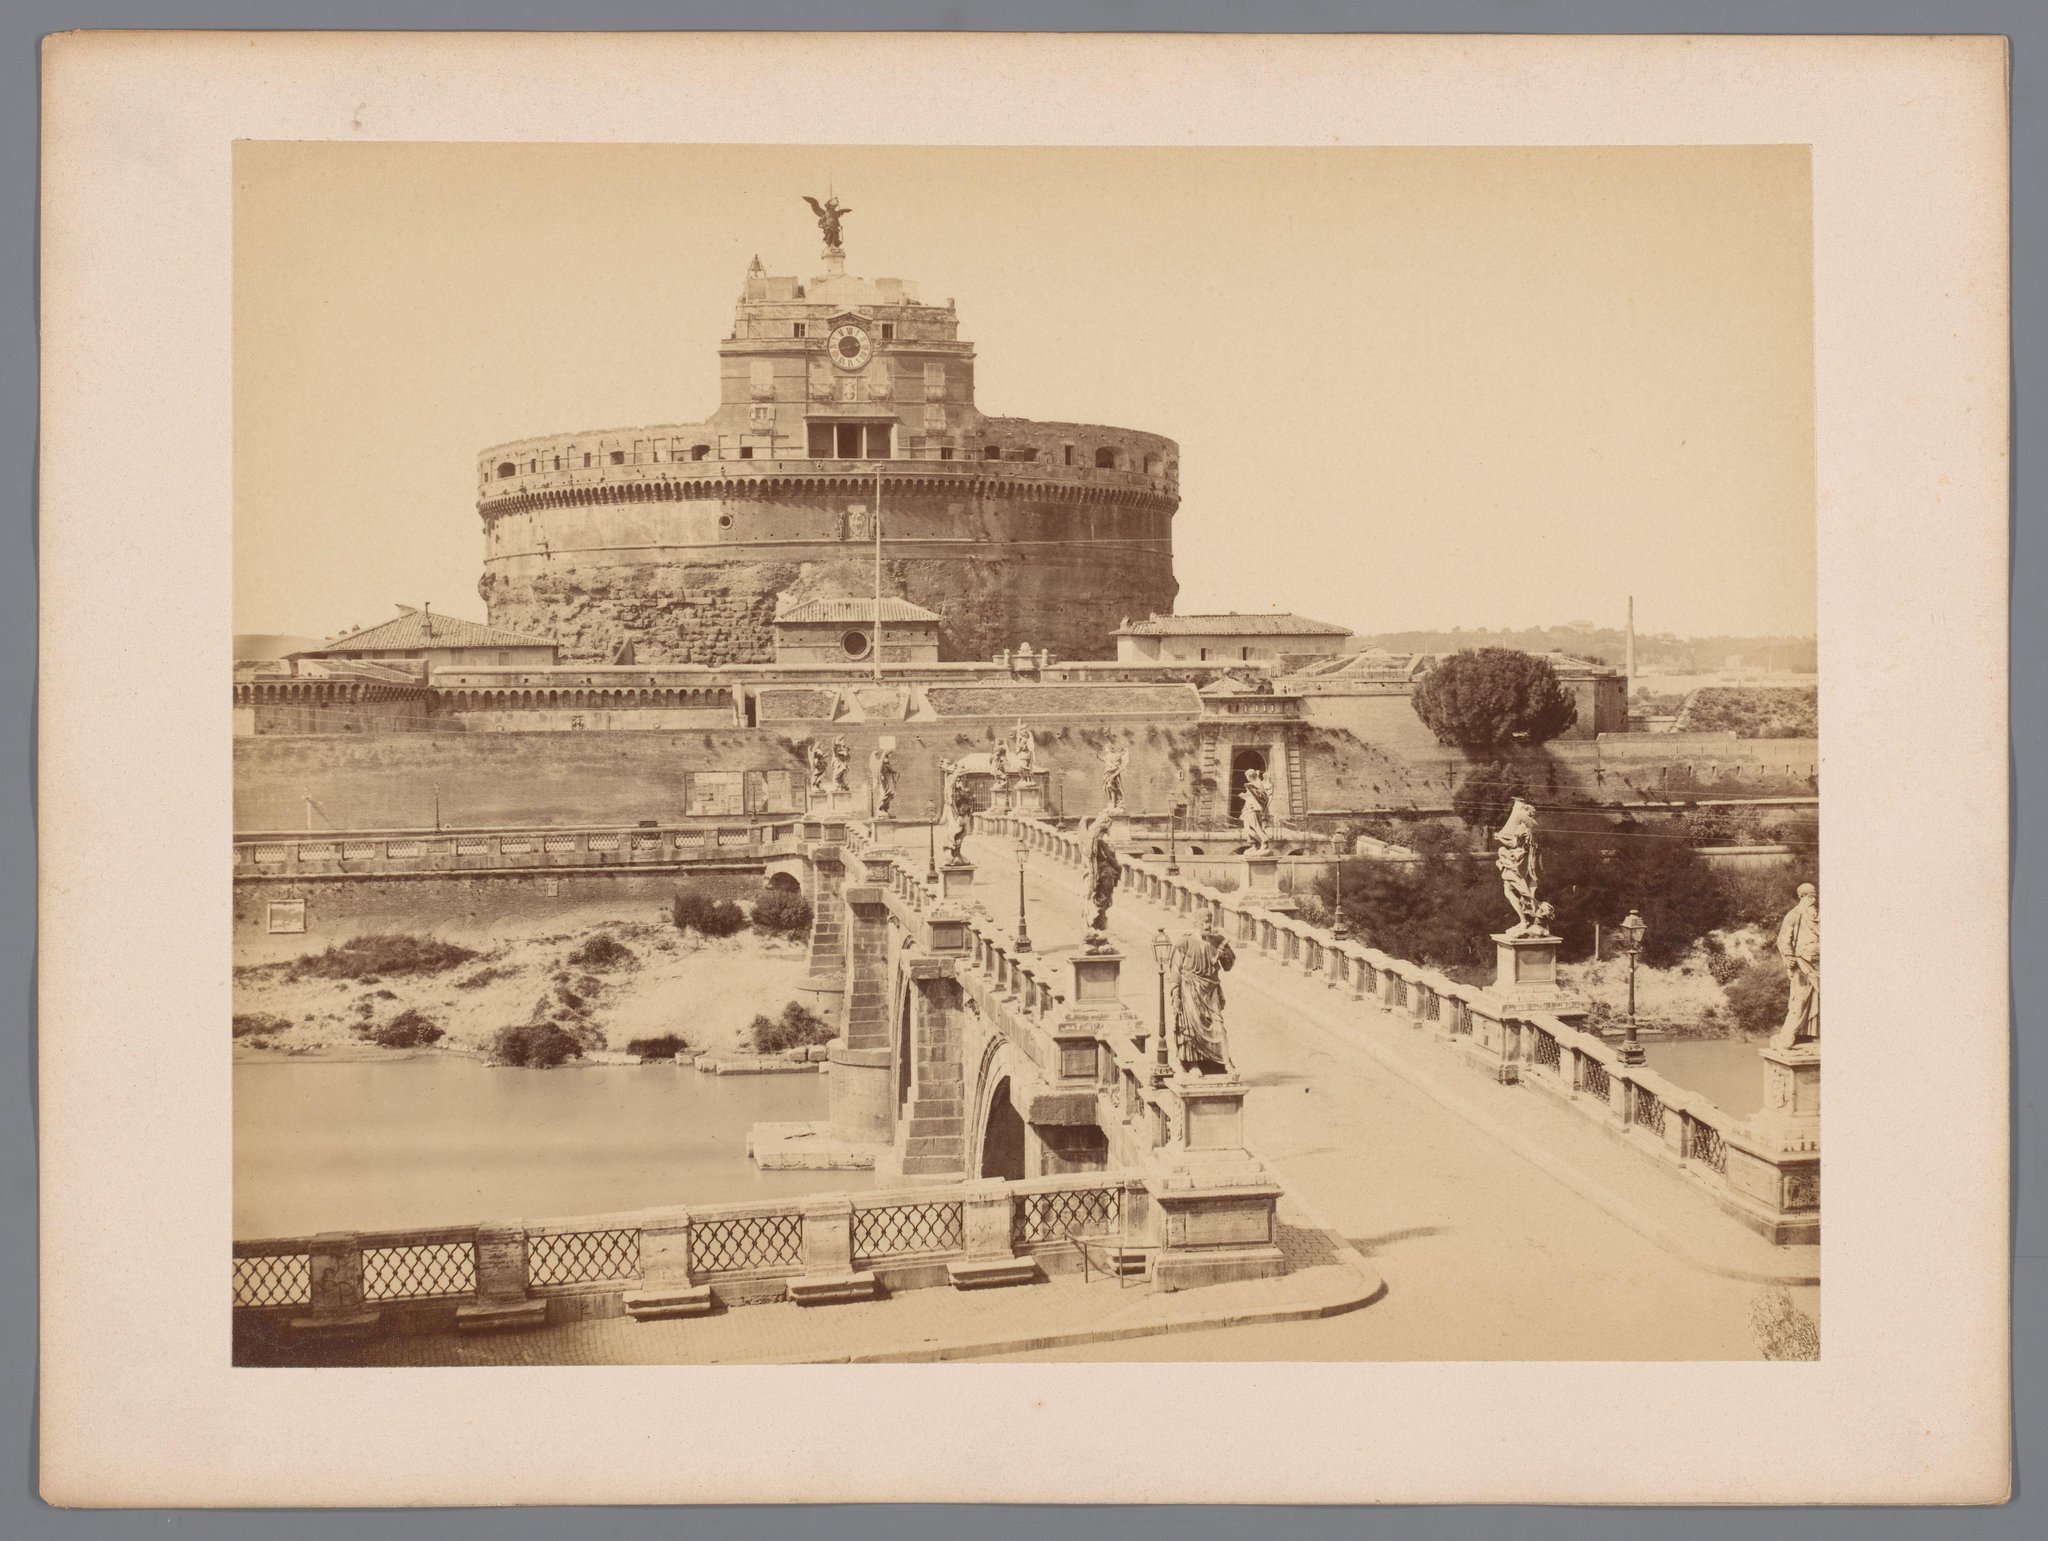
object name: photograph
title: Gezicht op de Engelenburcht en de Engelenbrug te Rome, Italië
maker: Anonymous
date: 1851-1900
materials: cardboard, paper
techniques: albumen print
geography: rome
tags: castle, bridge